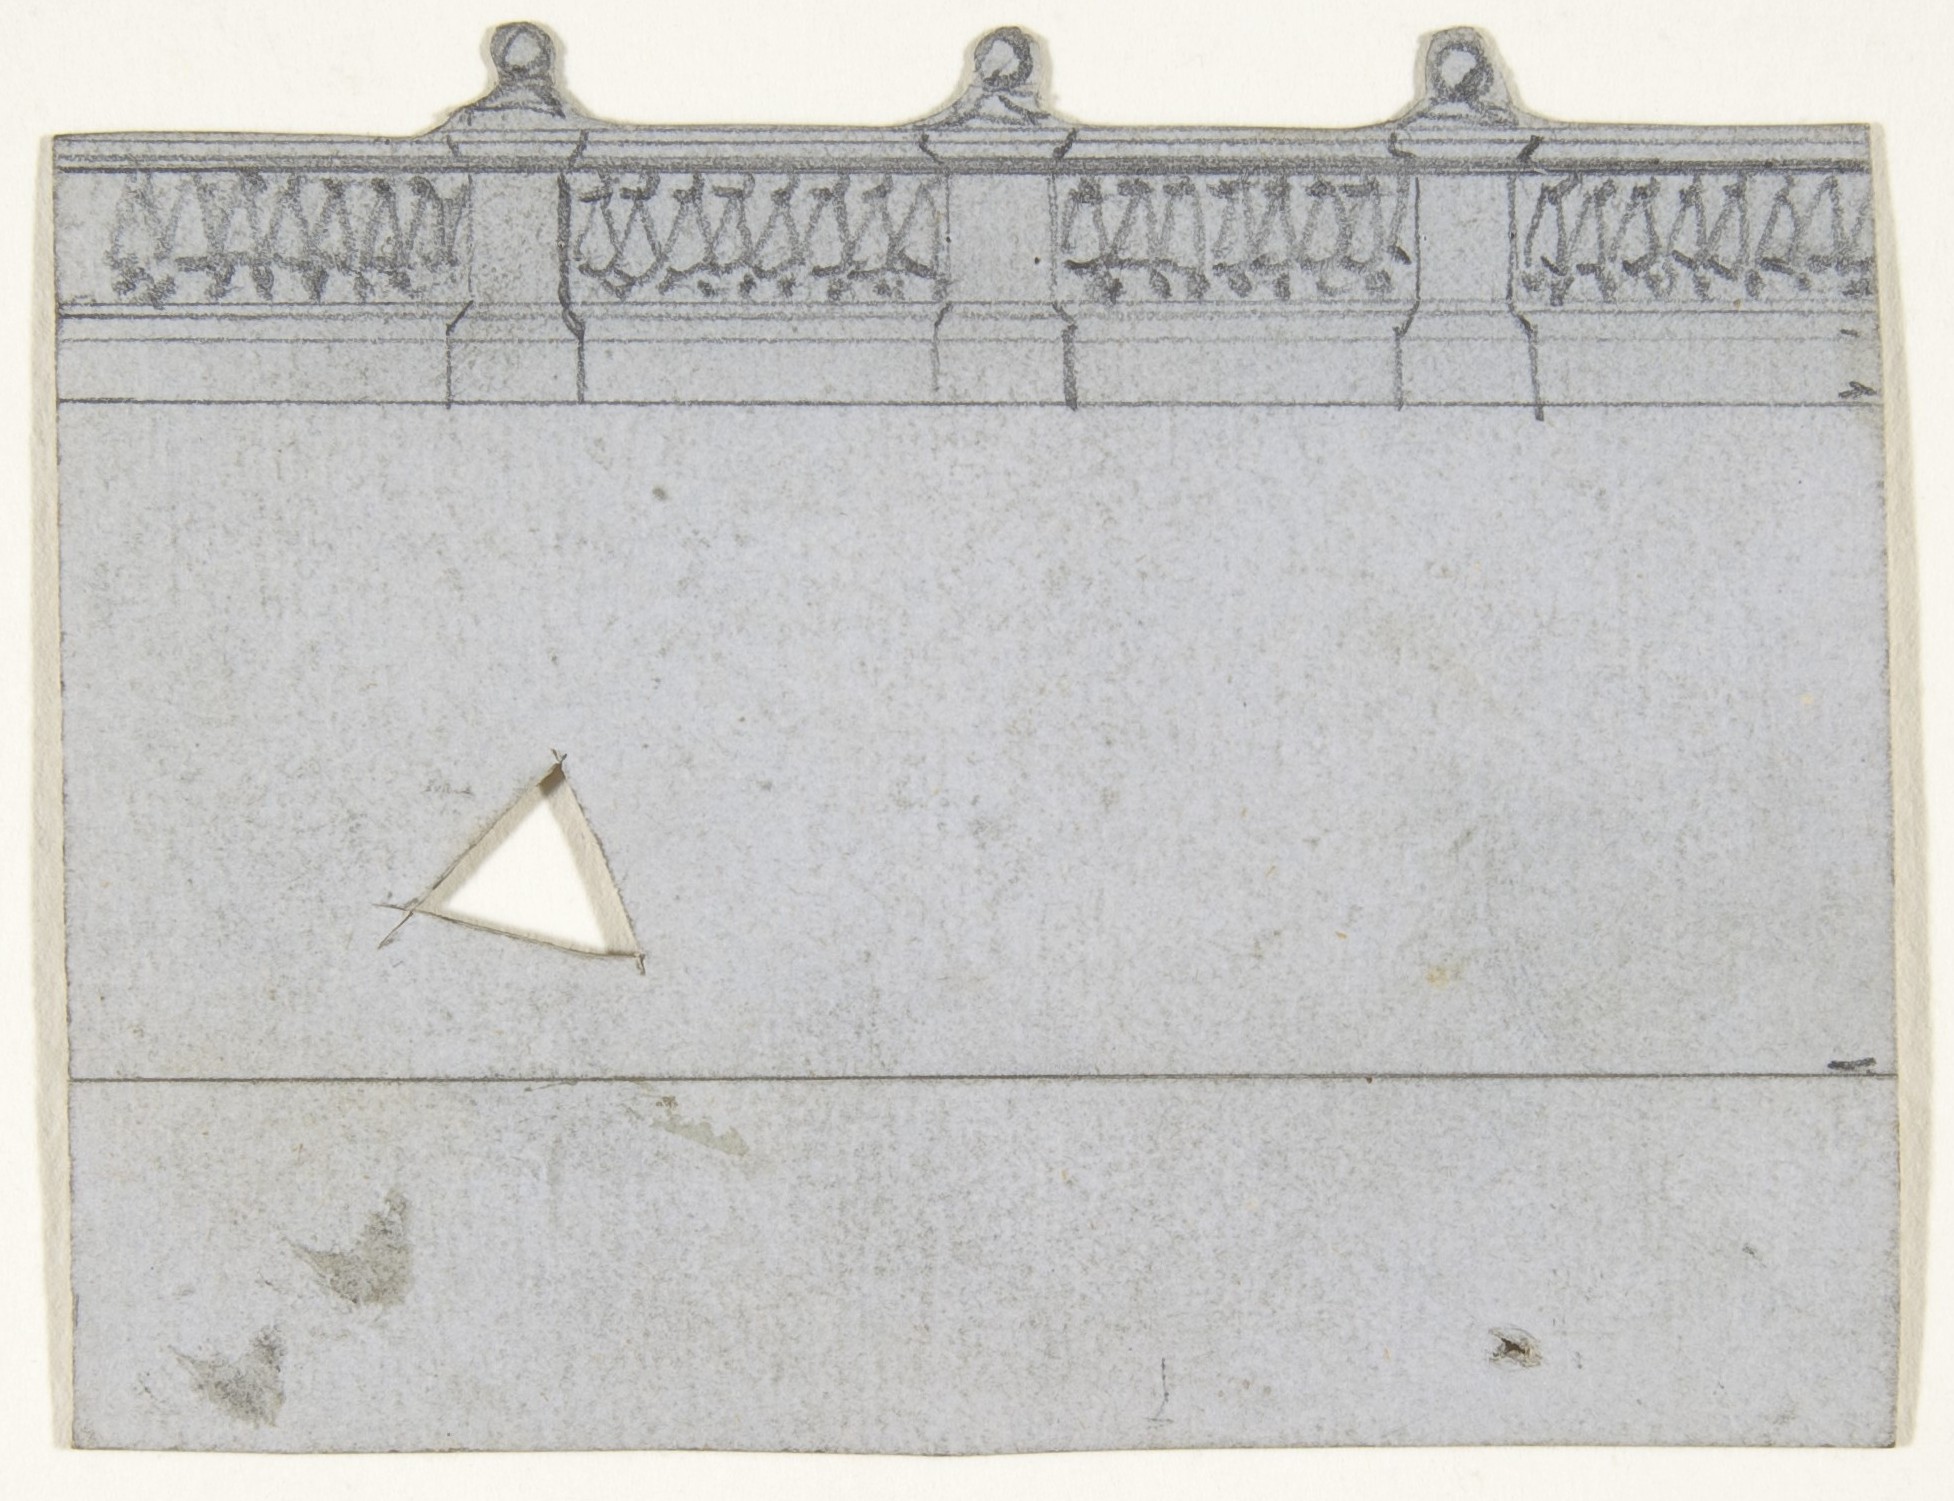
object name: drawing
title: Design for a Stage Set at the Opéra, Paris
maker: eugène cicéri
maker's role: artist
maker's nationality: french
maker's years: 1813-1890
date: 1830-1890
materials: graphite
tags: stage design